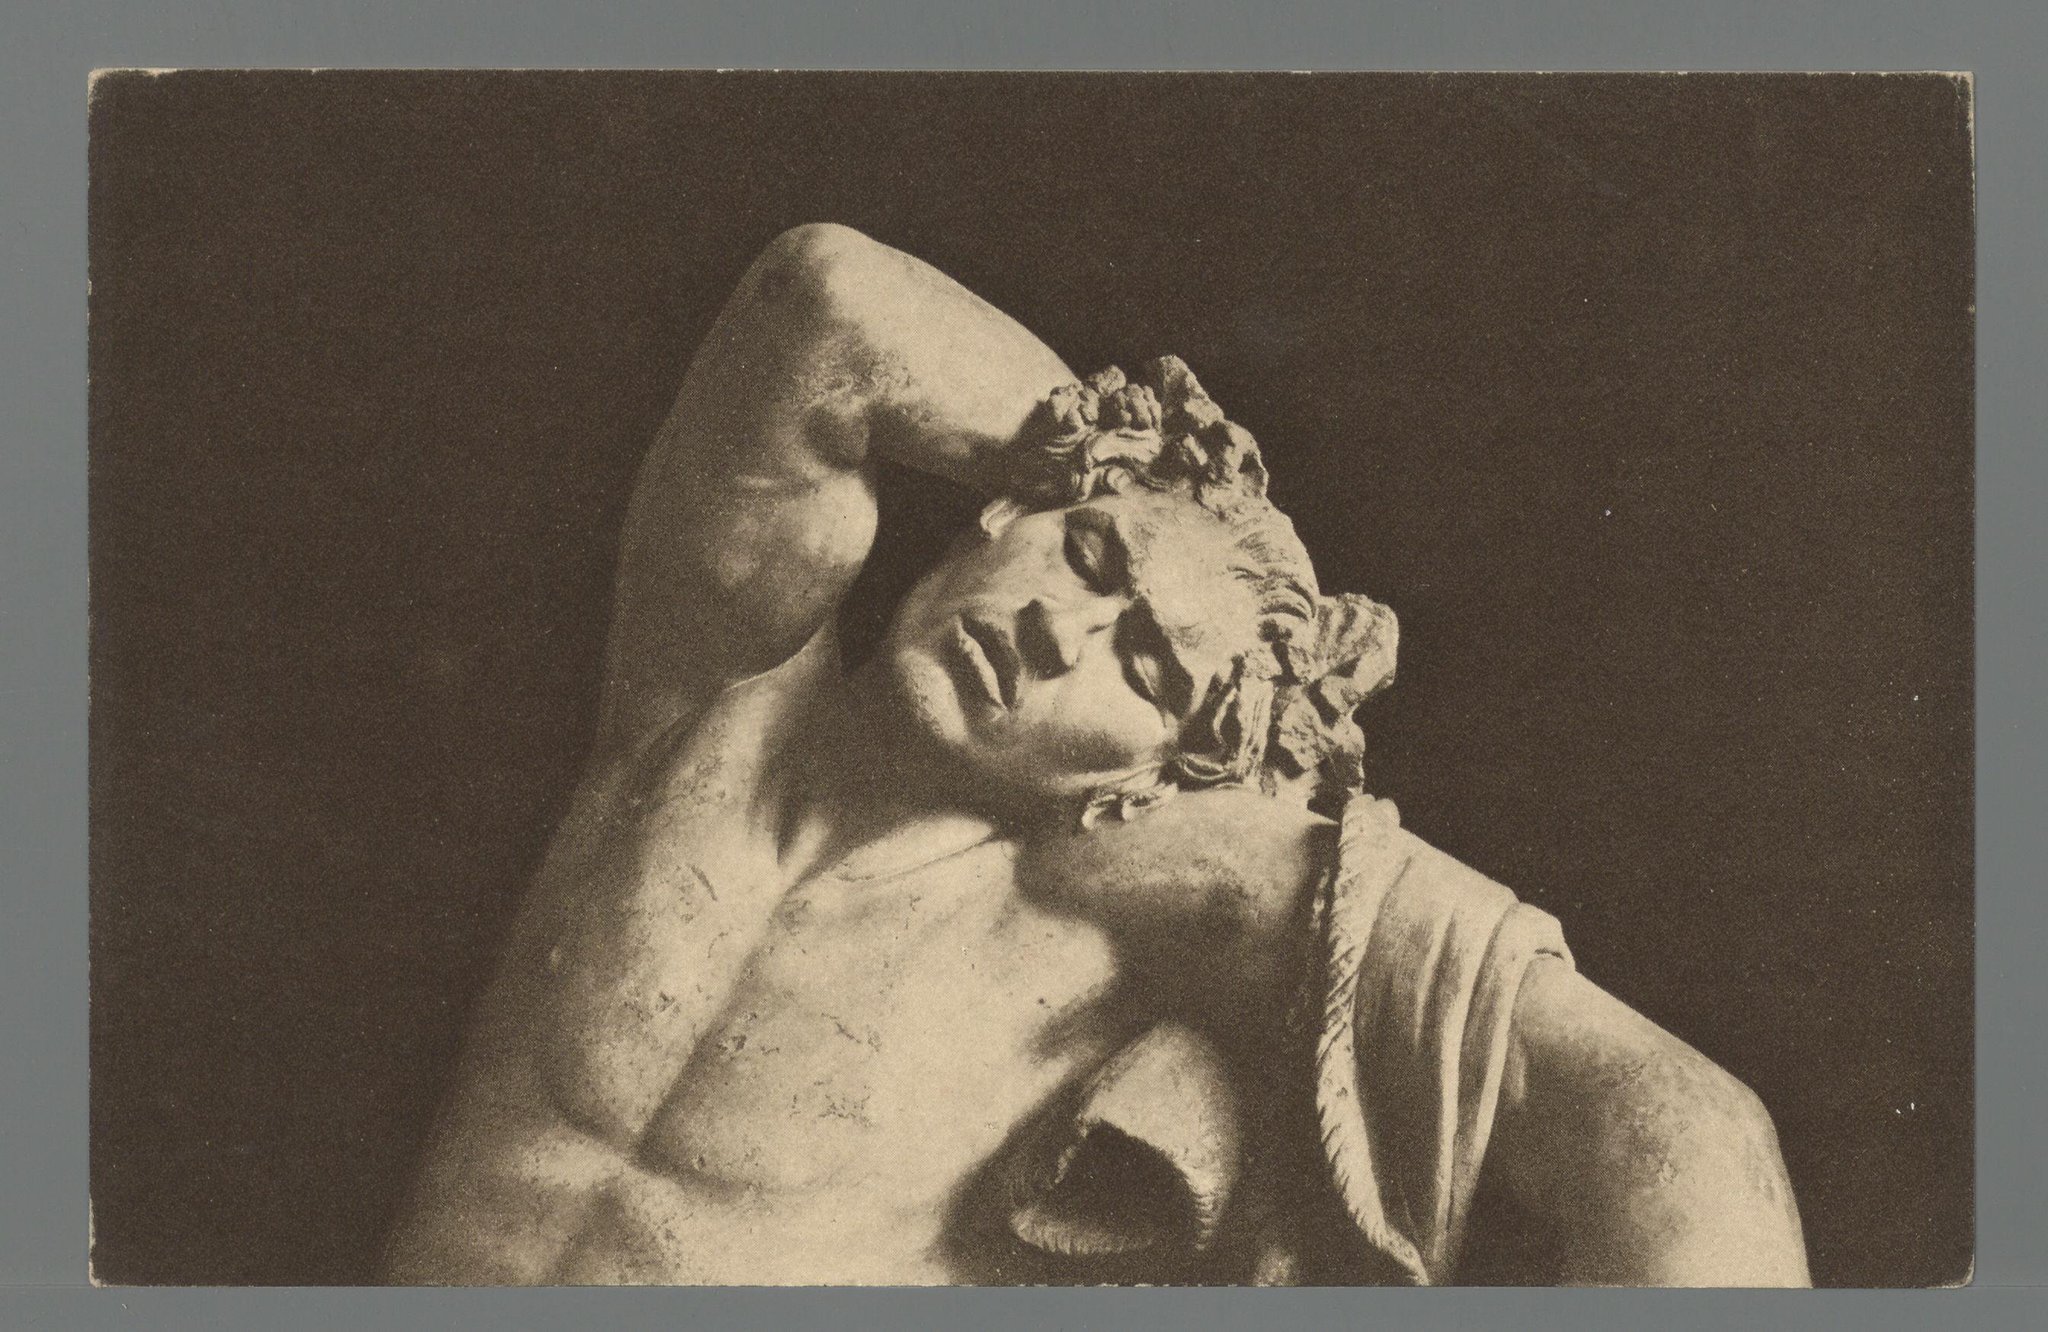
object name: photomechanical print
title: Barberinischer Faun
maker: Anonymous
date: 1905-1930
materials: cardboard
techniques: rotogravure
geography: munich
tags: monument, statue, permanent exhibition, museum